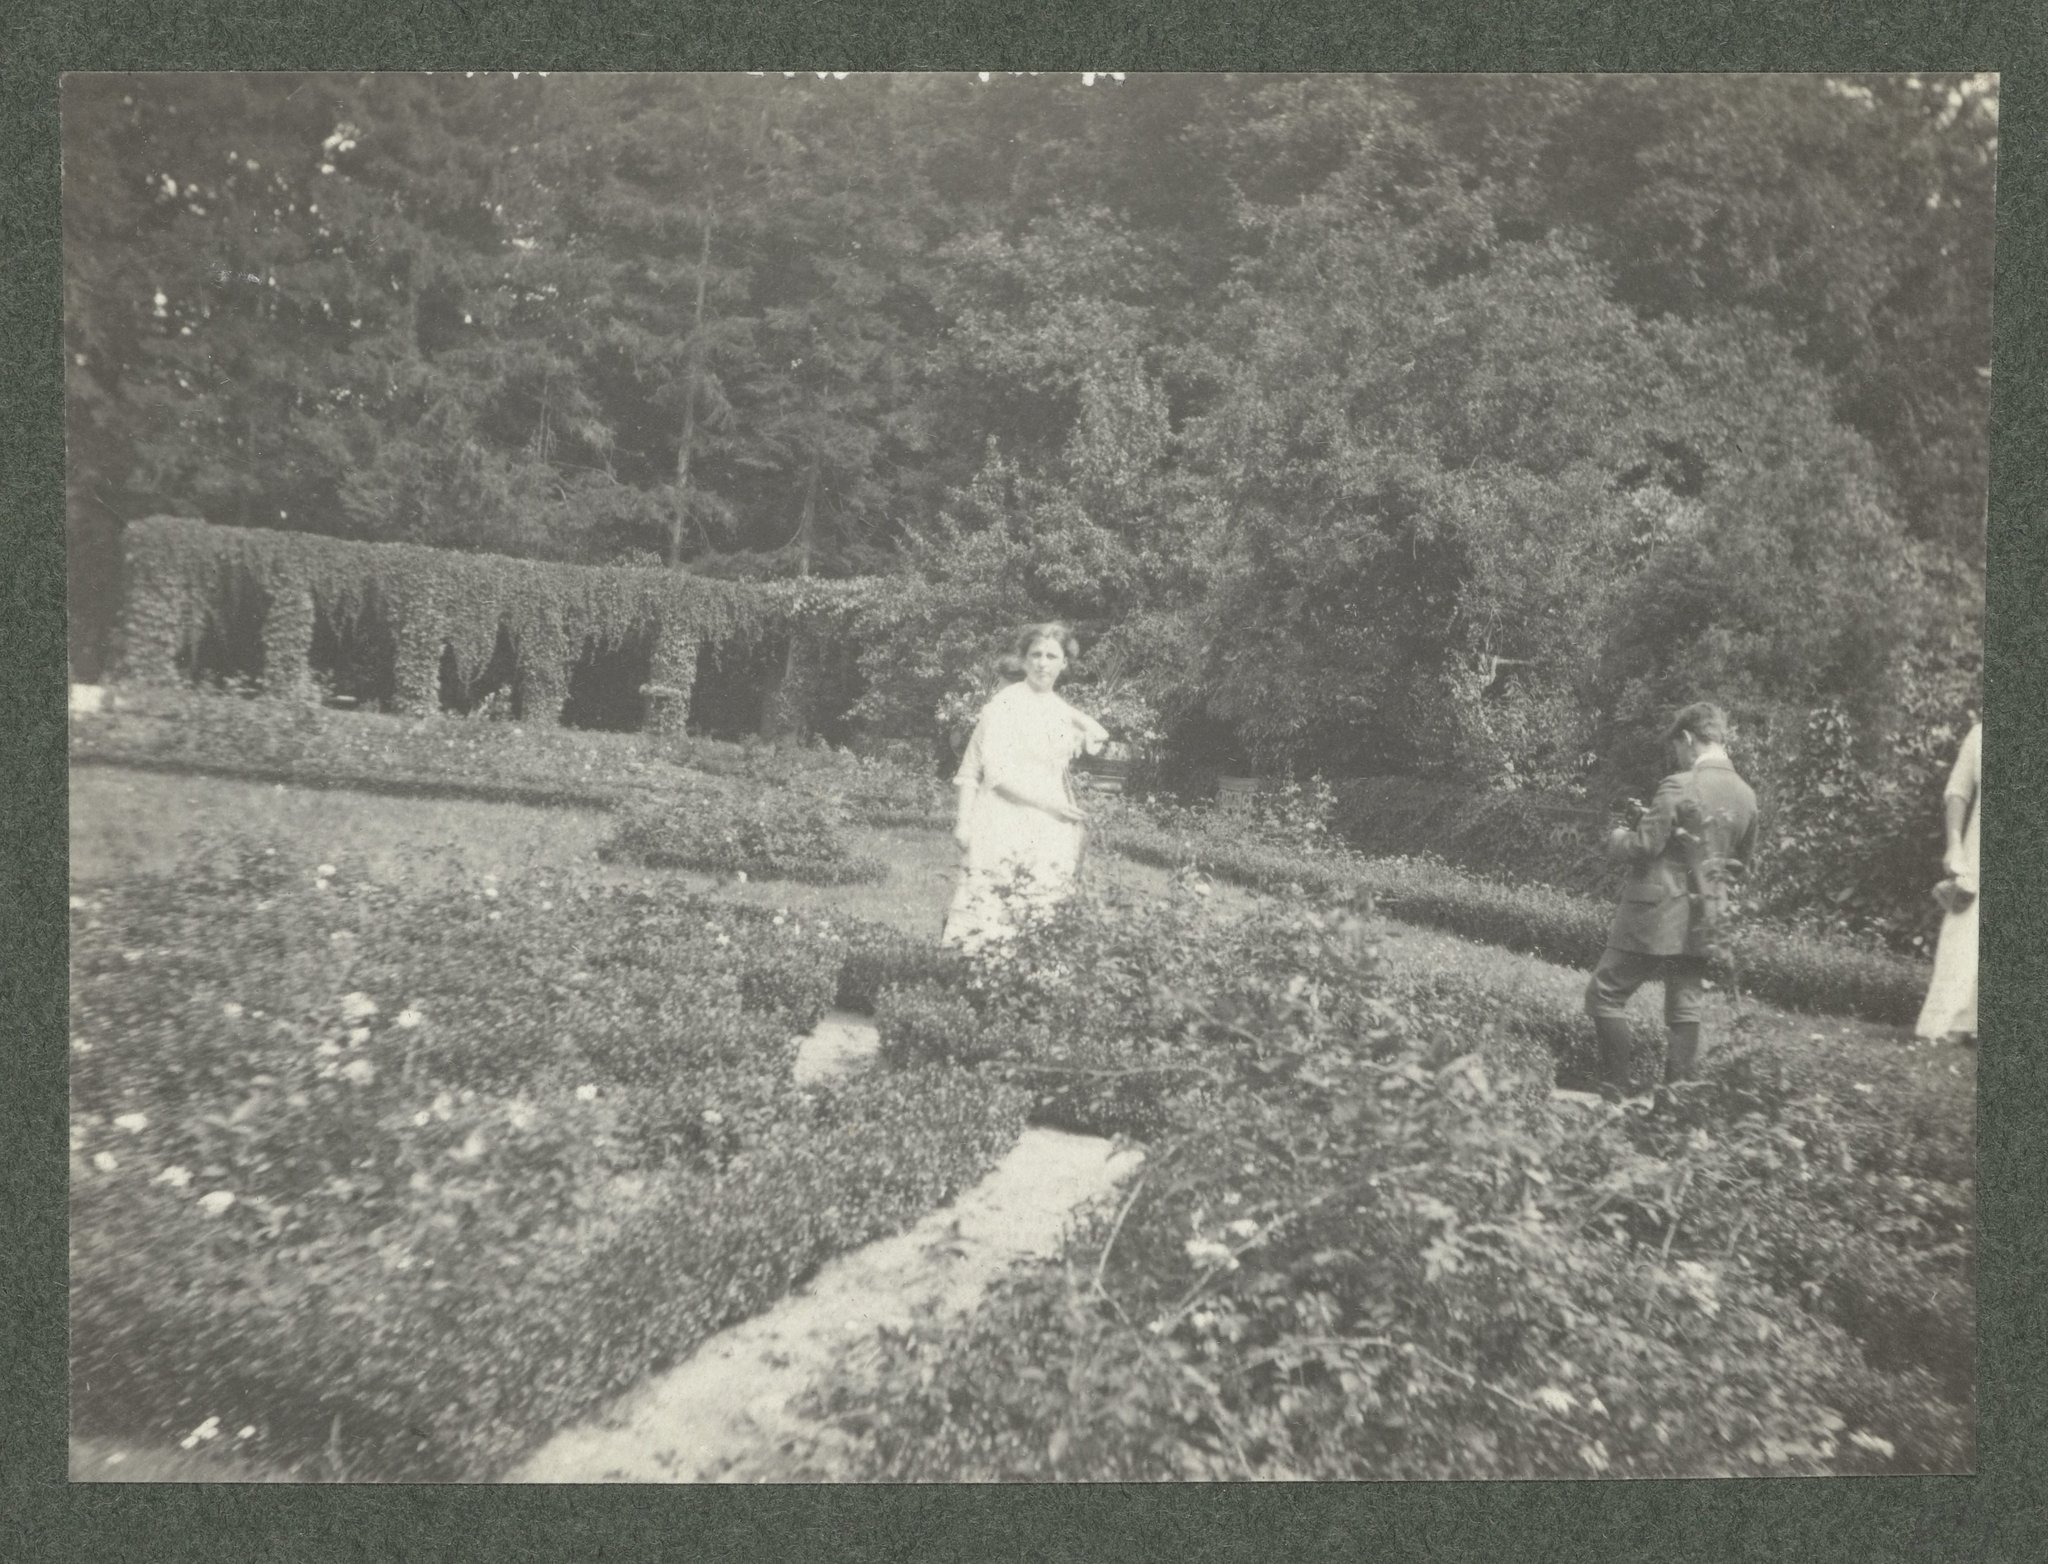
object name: photograph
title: In de rozentuin van landgoed Pauw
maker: geldolph adriaan kessler (dolph)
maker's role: fotograaf, industrieel, voetballer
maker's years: 1884-1945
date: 1913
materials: paper, photographic support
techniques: photography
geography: netherlands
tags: huize de paauw